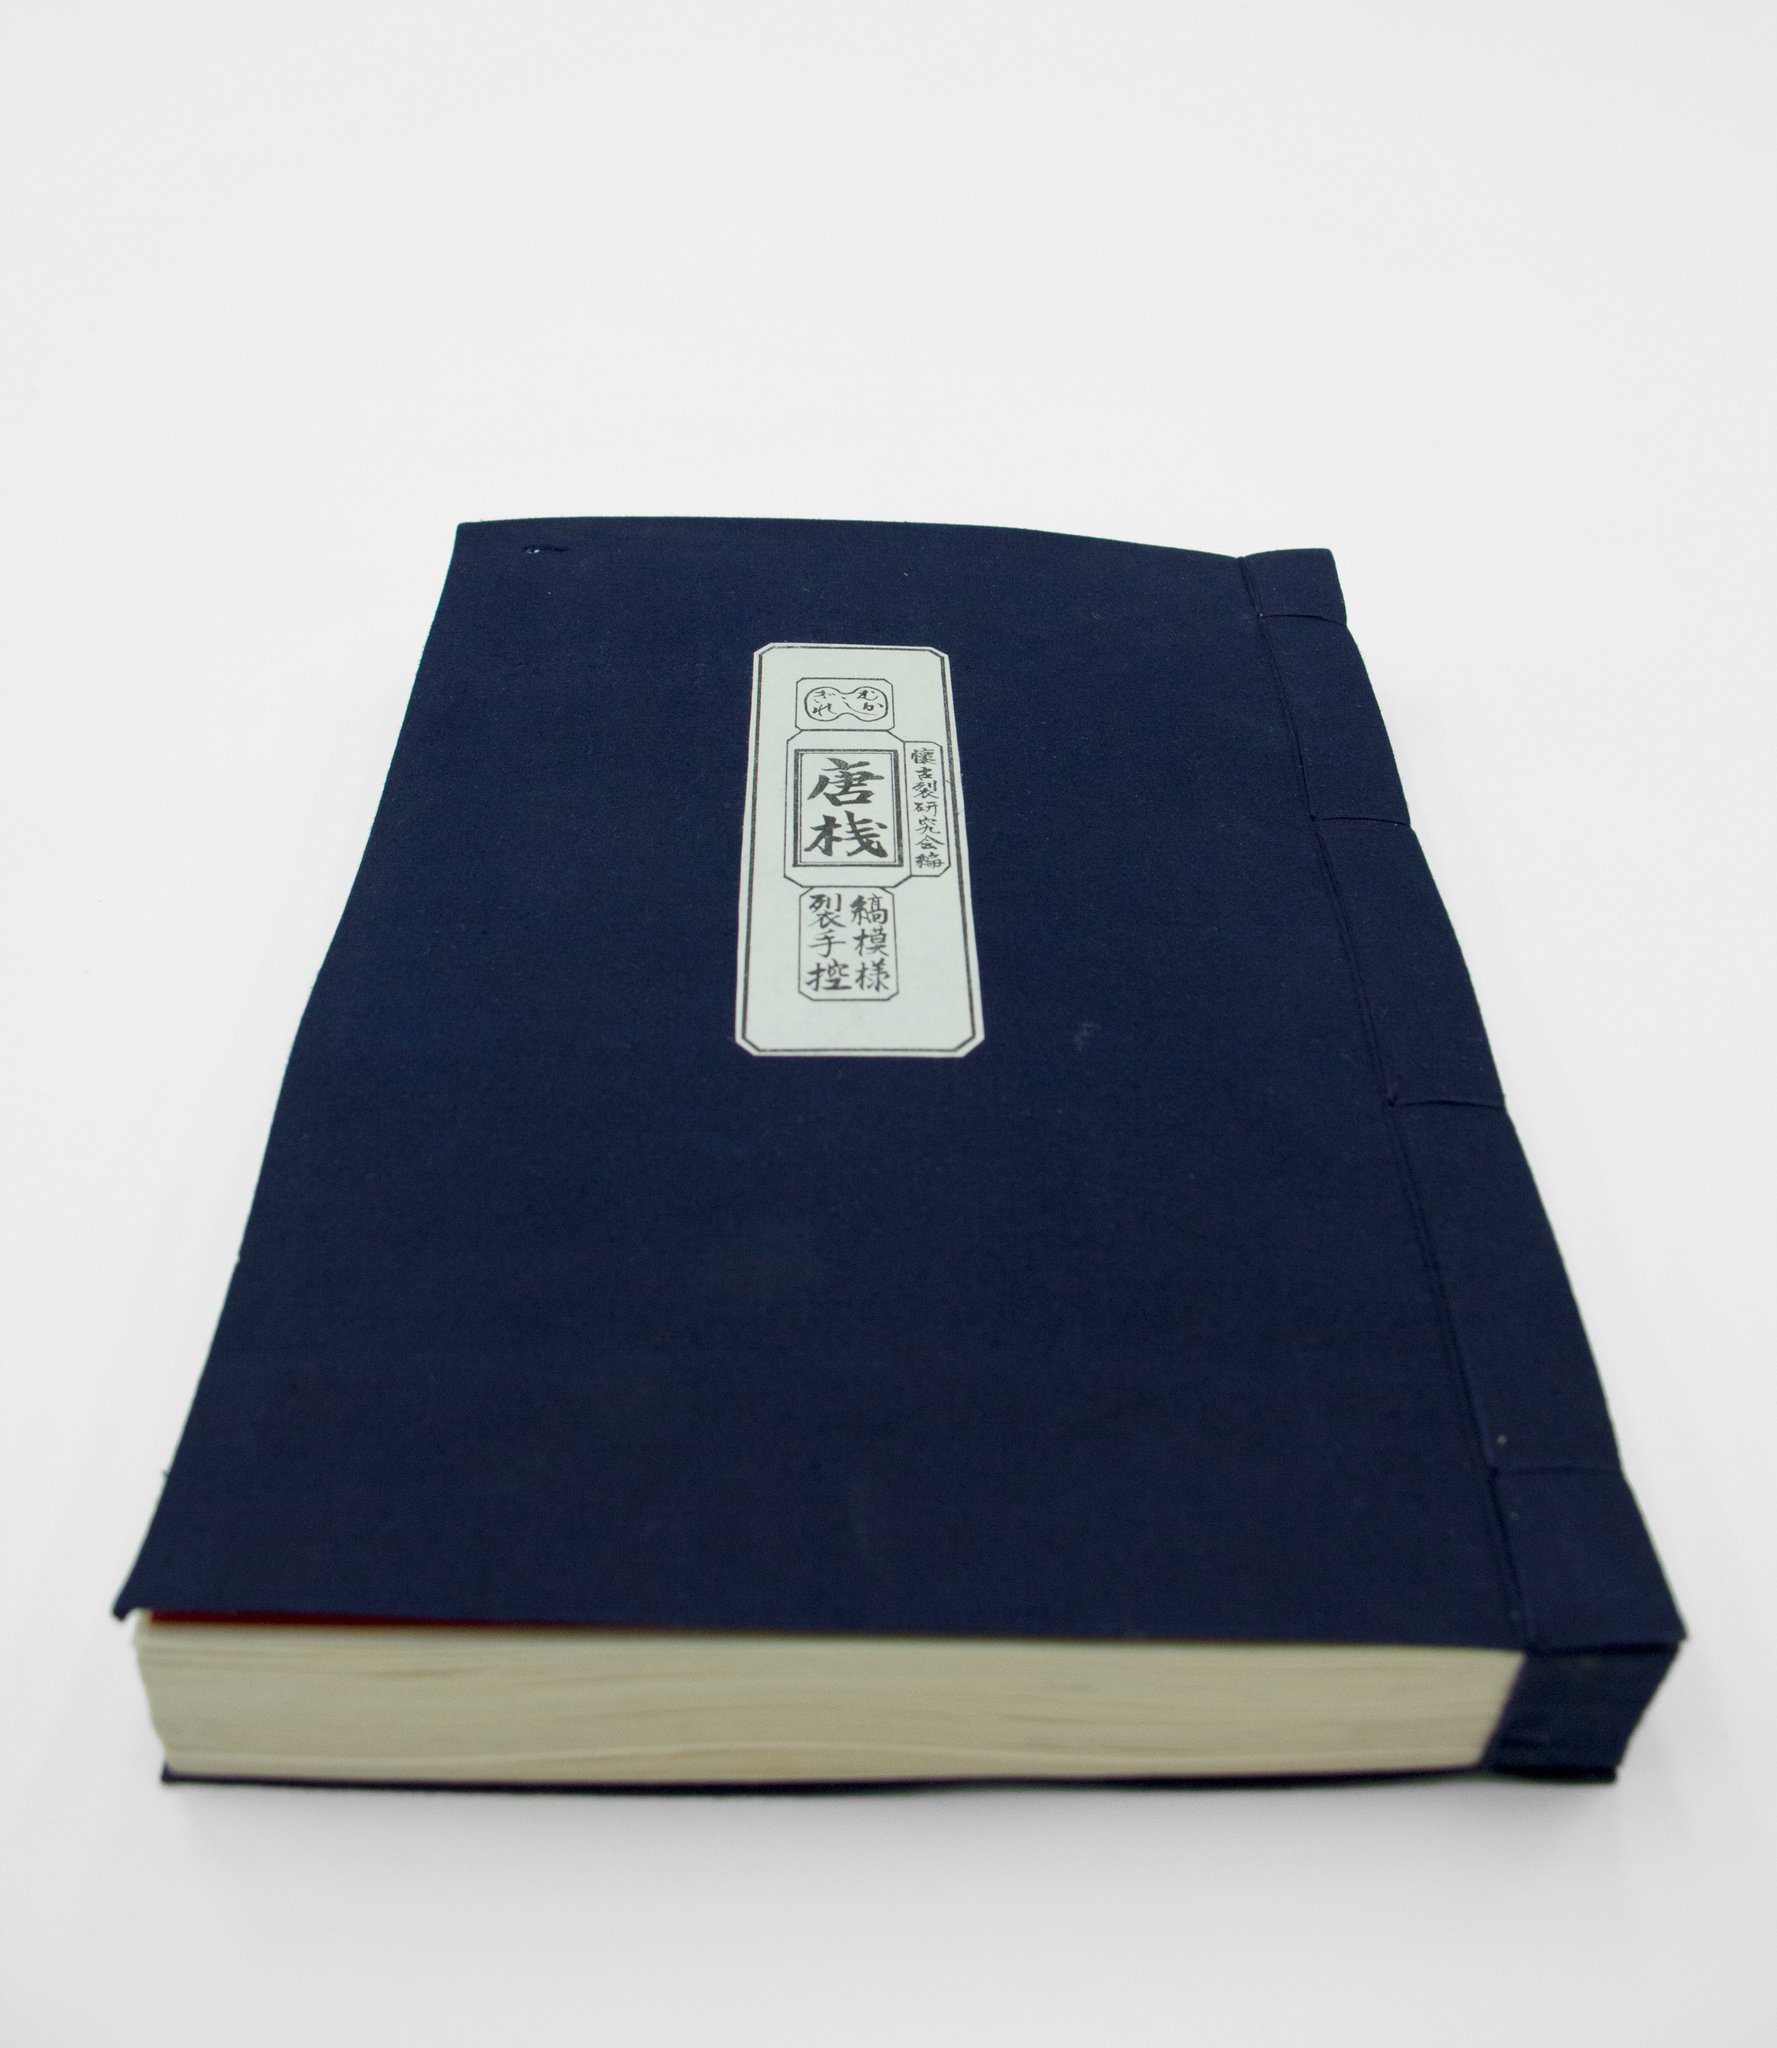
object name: textile sample book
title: Tozan--shimamoyogire tebikae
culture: japanese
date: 1801-1900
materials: cotton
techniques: dyeing, weave